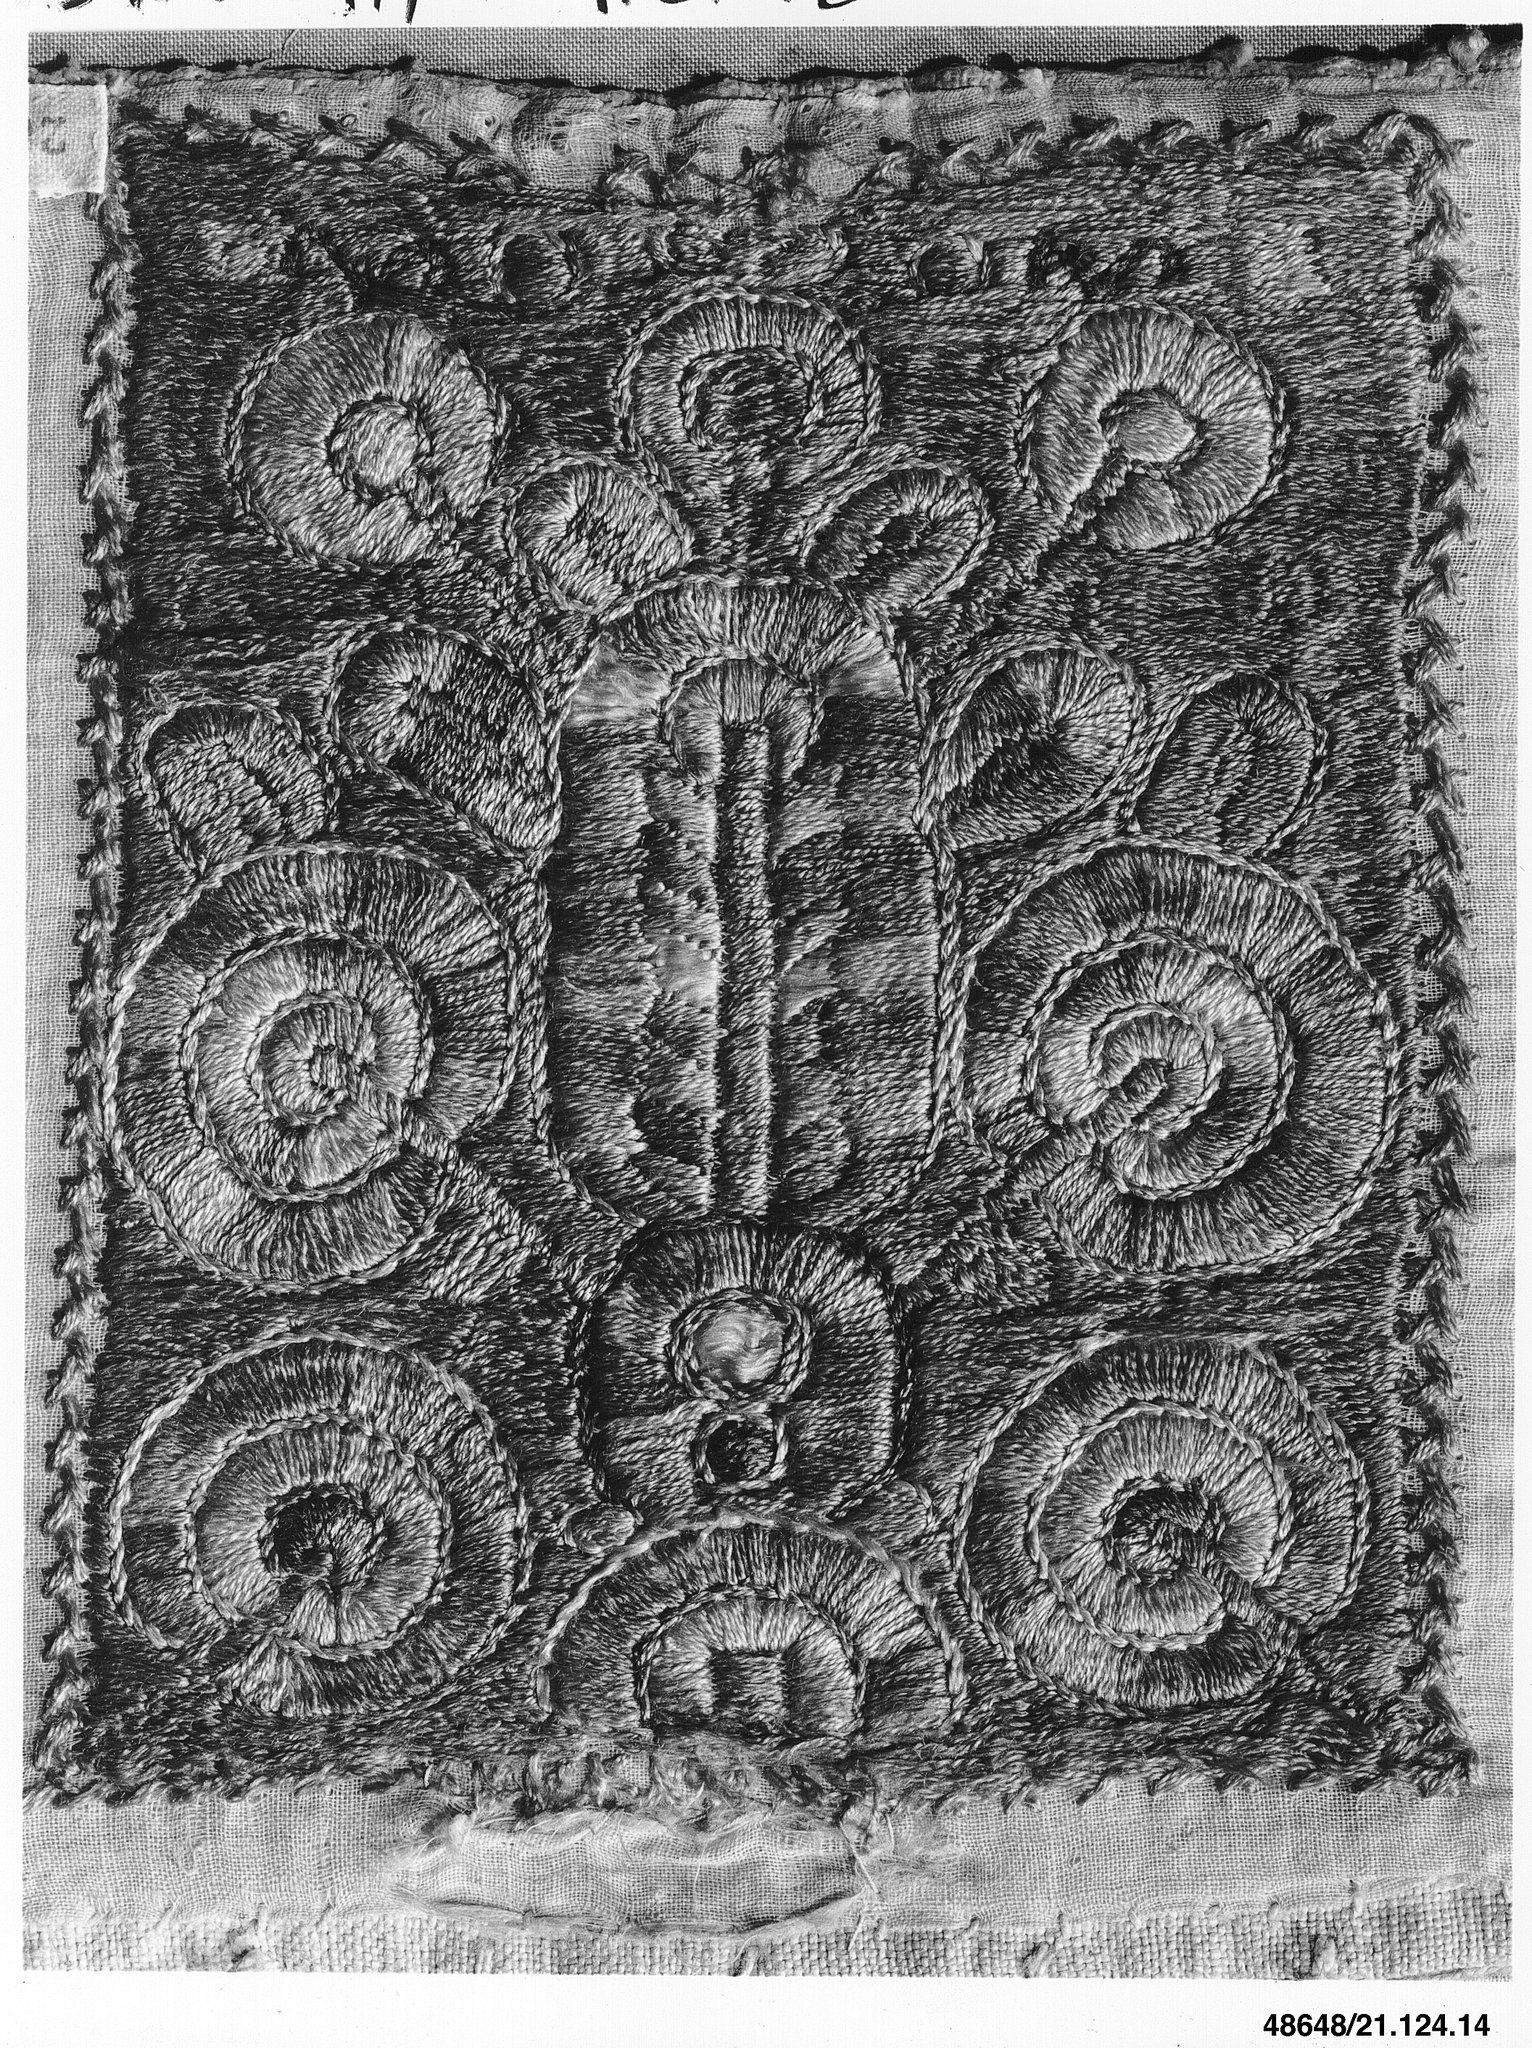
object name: cap fragment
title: Cap top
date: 1801-1900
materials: linen, silk